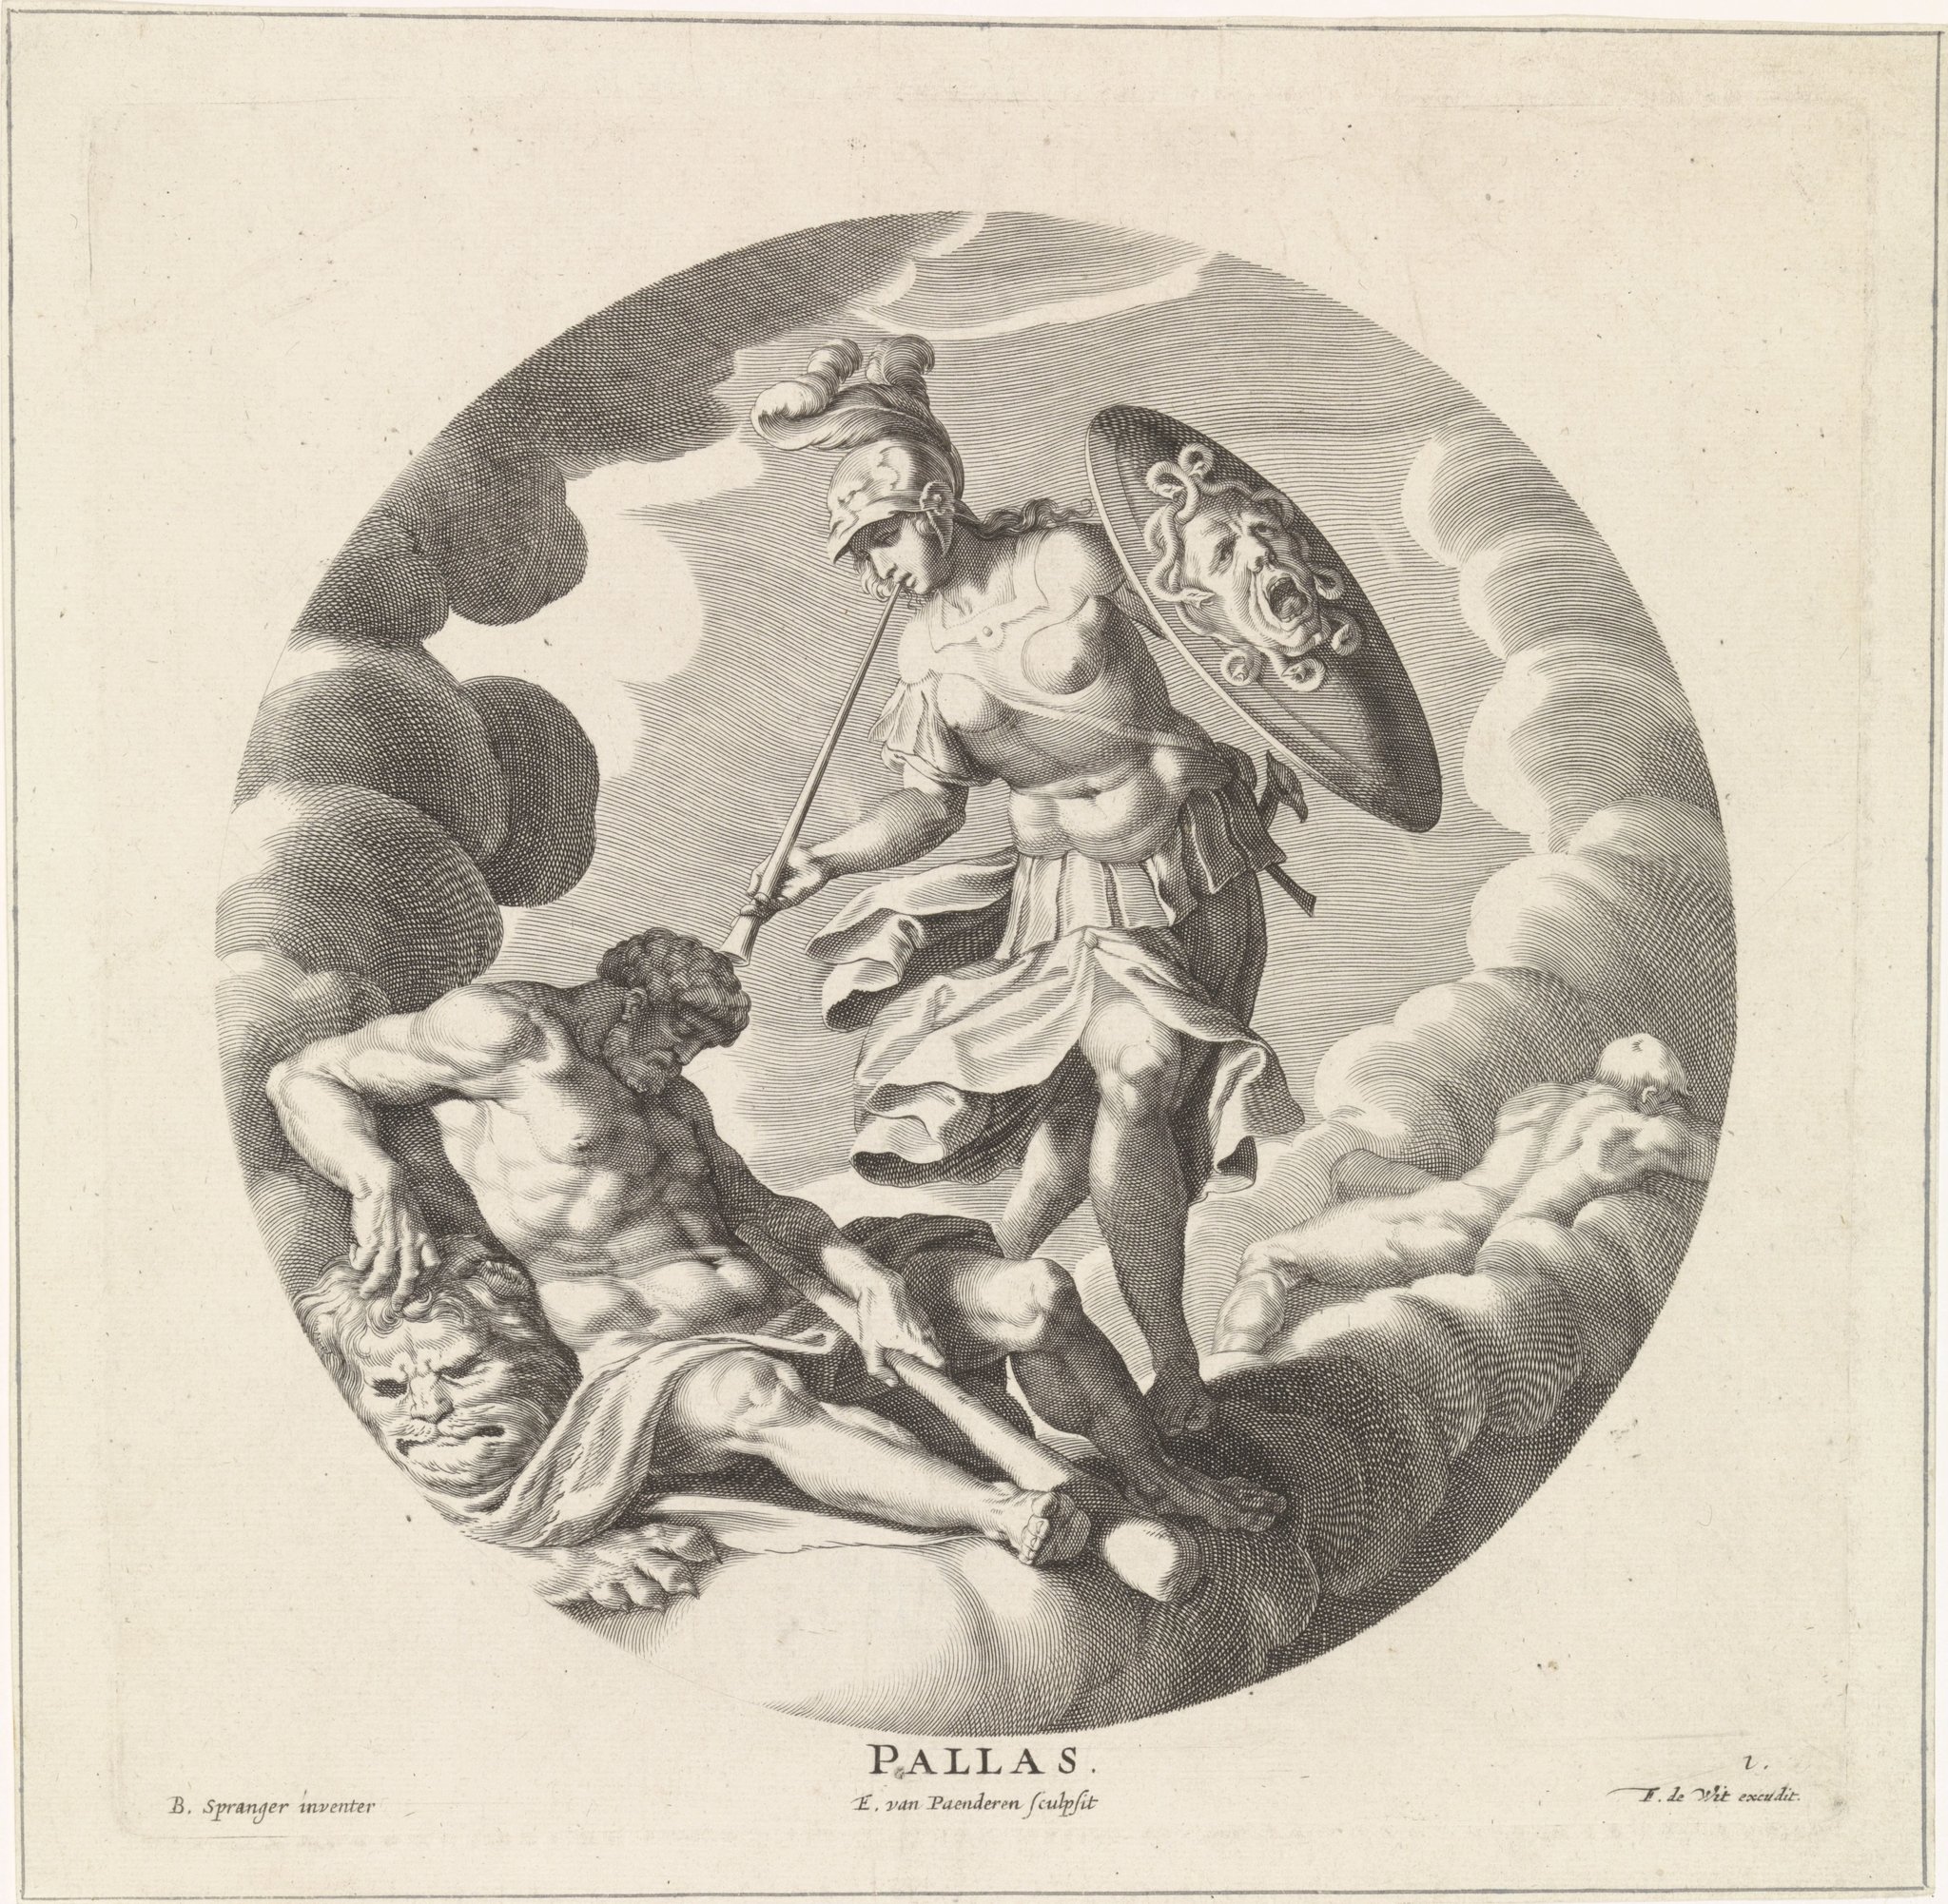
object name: print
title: Godinnen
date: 1590-1637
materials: paper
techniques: engraving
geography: antwerp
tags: (story of) hercules (heracles), (story of) minerva (pallas, athena)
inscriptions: collector's mark: Lugt 2228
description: Wolkendek met Minerva in wapenrusting, blazend op een bazuin. Naast haar de slapende Hercules. De voorstelling is gevat in een ronde omlijsting. Eerste prent uit een serie van drie met godinnen.